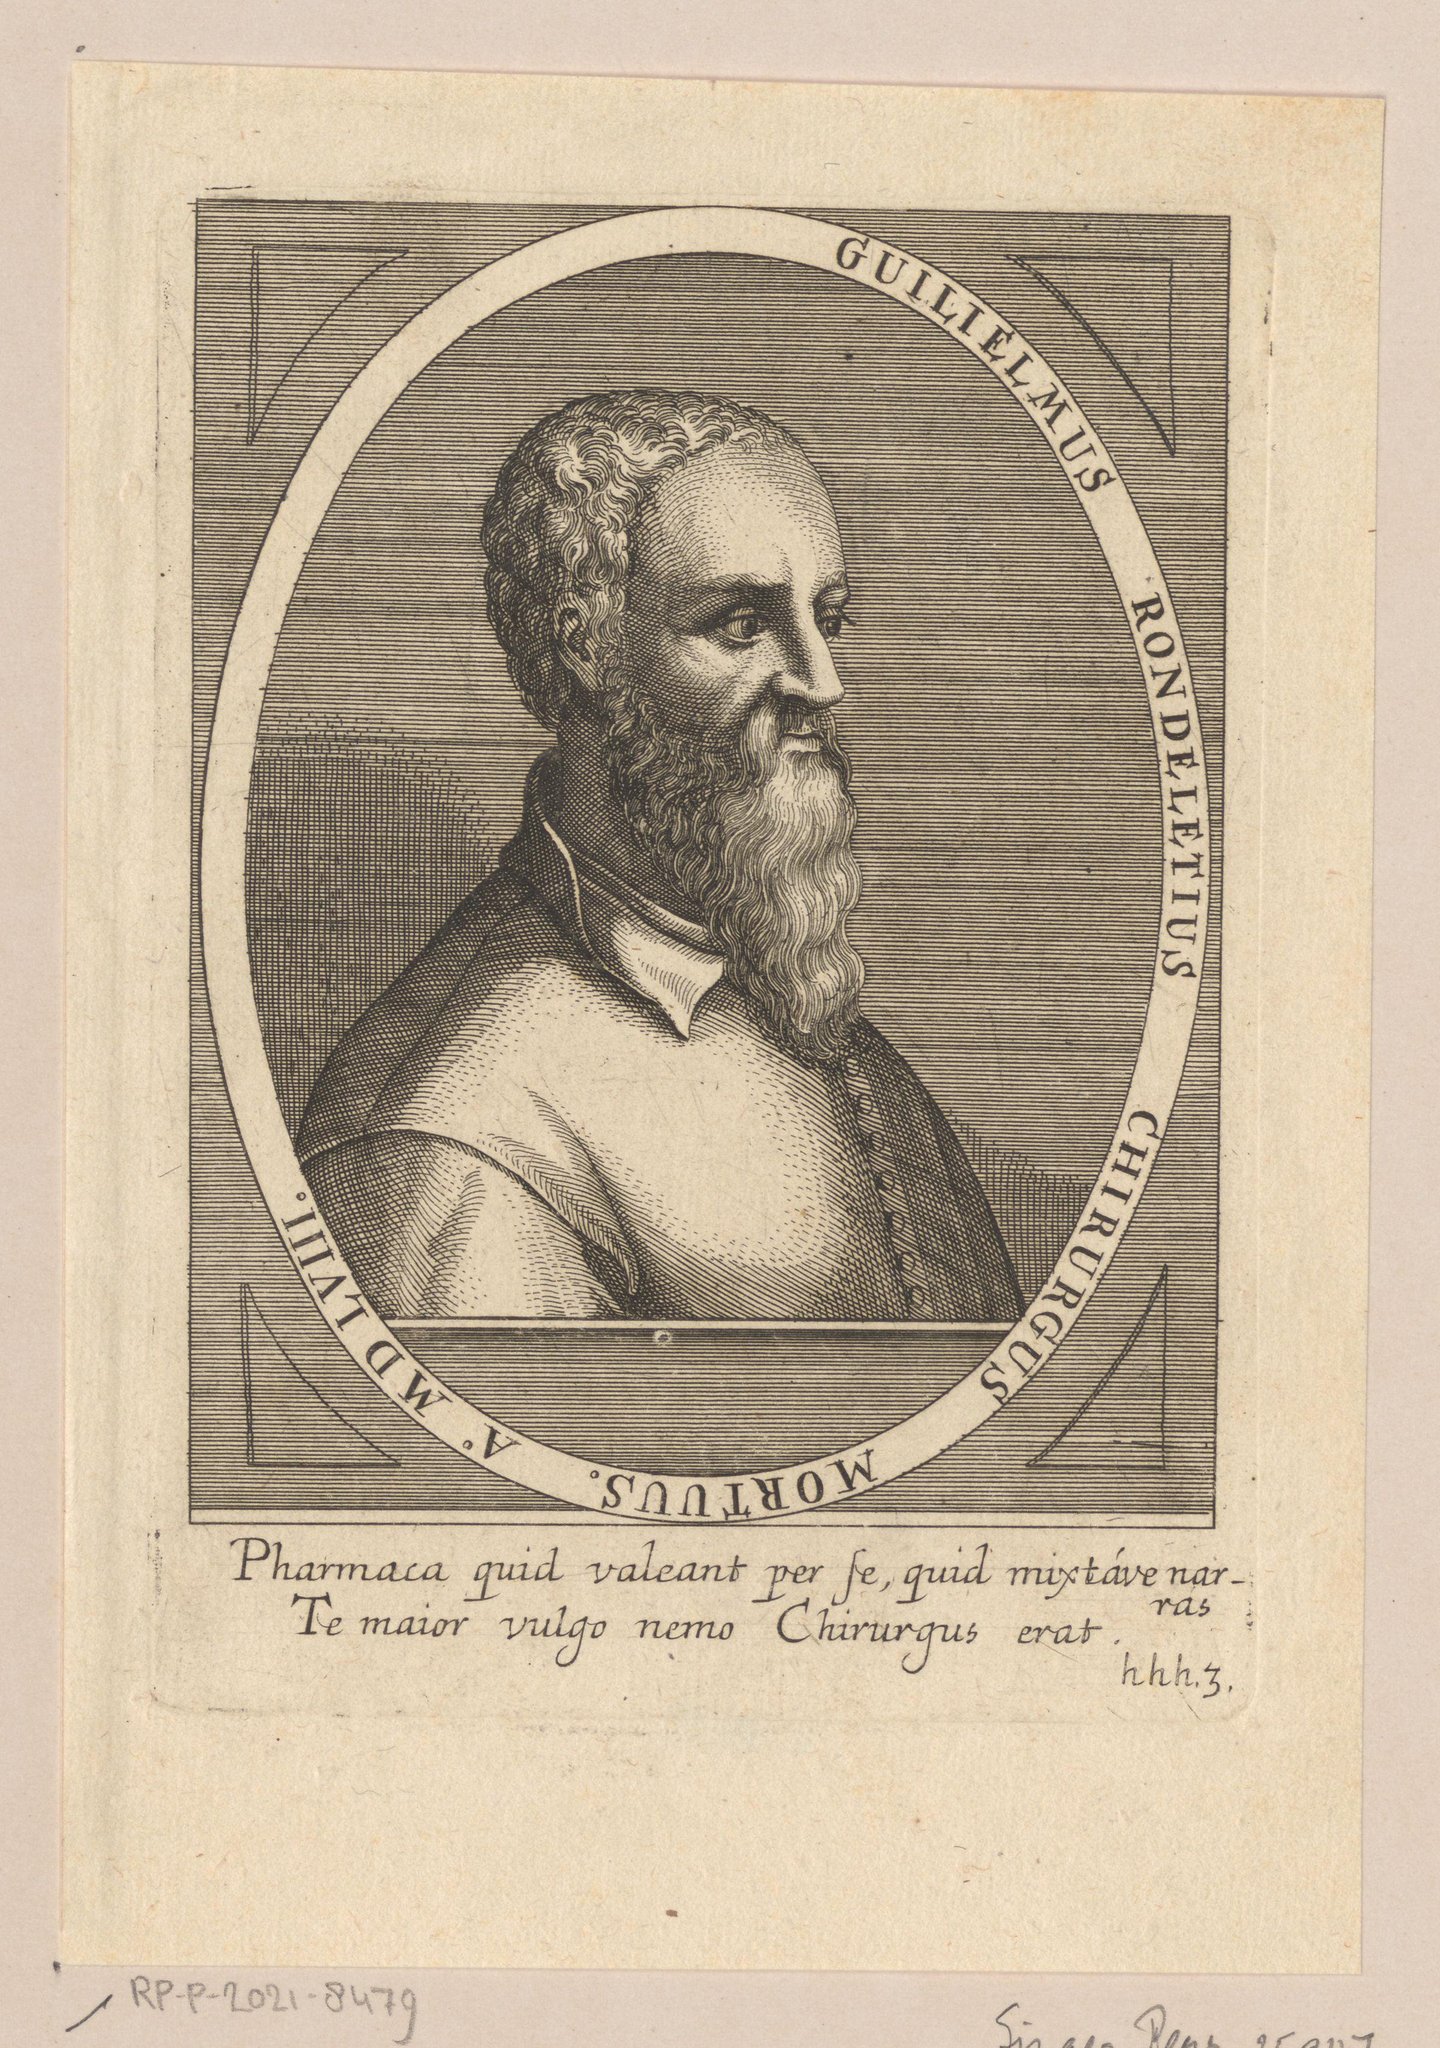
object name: print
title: Bibliotheca chalcographica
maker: clemens ammon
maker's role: print maker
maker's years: 1627-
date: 1652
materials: paper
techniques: etching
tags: historical persons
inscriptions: collector's mark: Lugt 2233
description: Prent mogelijk uit: Boissard, Jean Jacques. Bibliotheca chalcographica (...). Frankfurt am Main: Johannes Ammon, 1652, dl. 7.